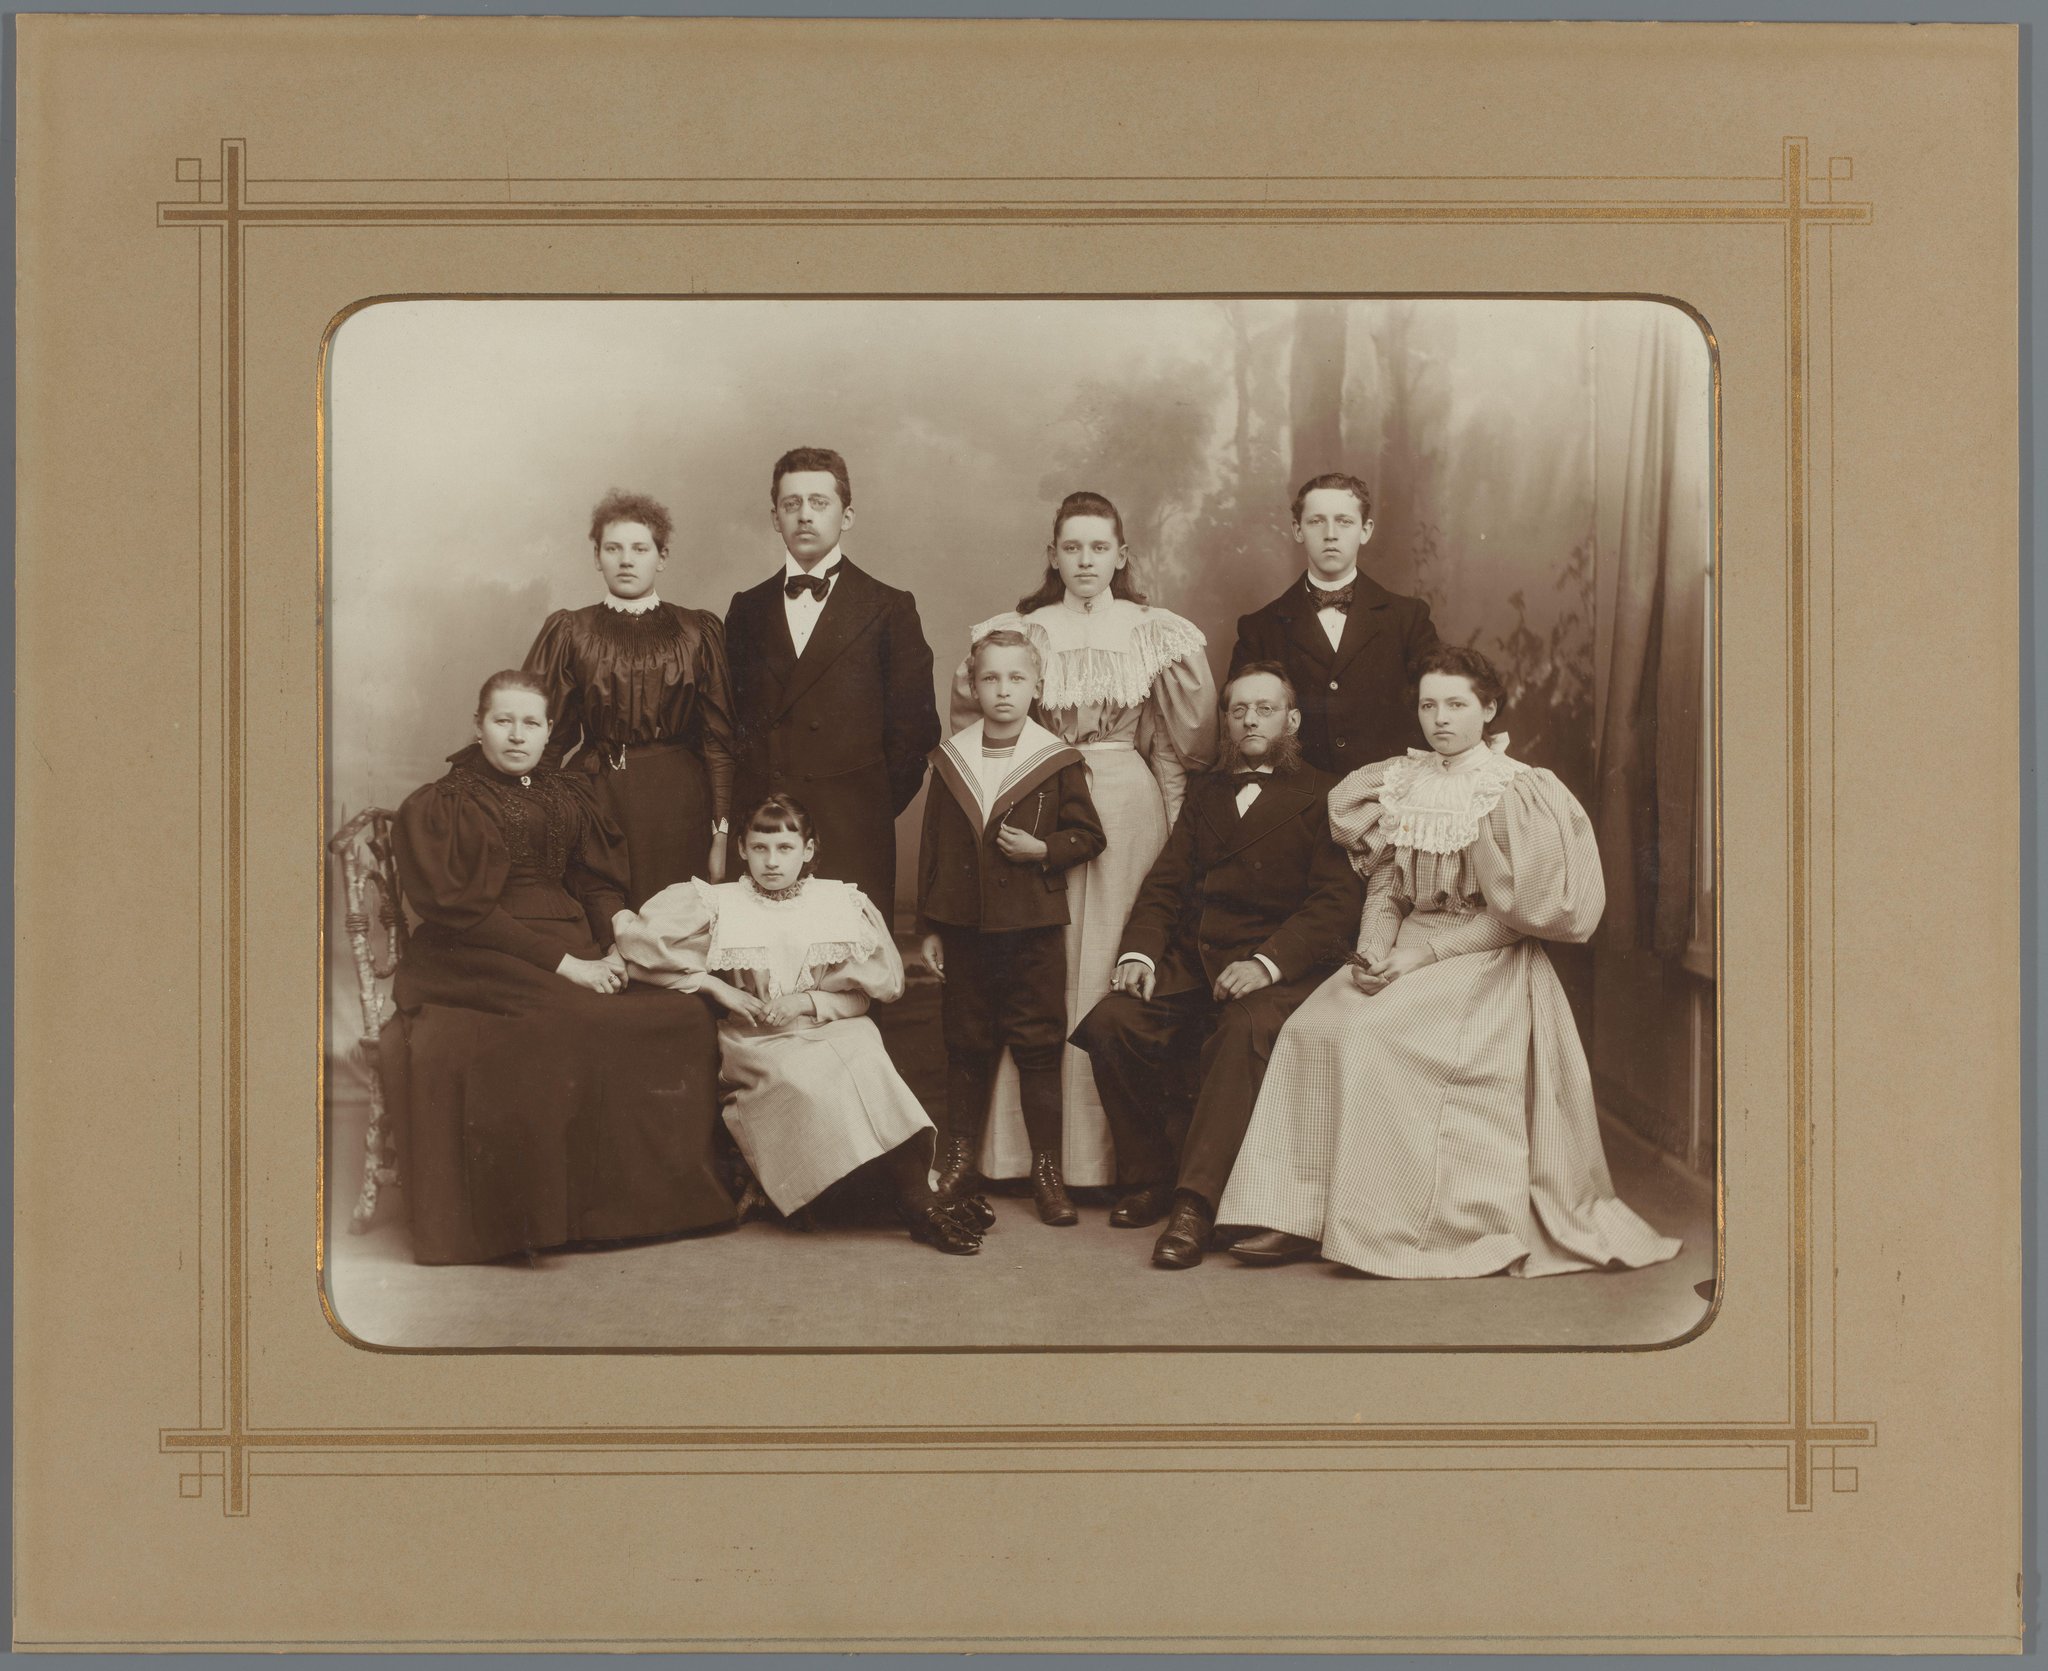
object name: photograph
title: Groepsportret van een onbekende familie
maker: Anonymous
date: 1890-1910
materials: paper, cardboard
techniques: collodion silver print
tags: anonymous historical persons portrayed in a group, in a group-portrait